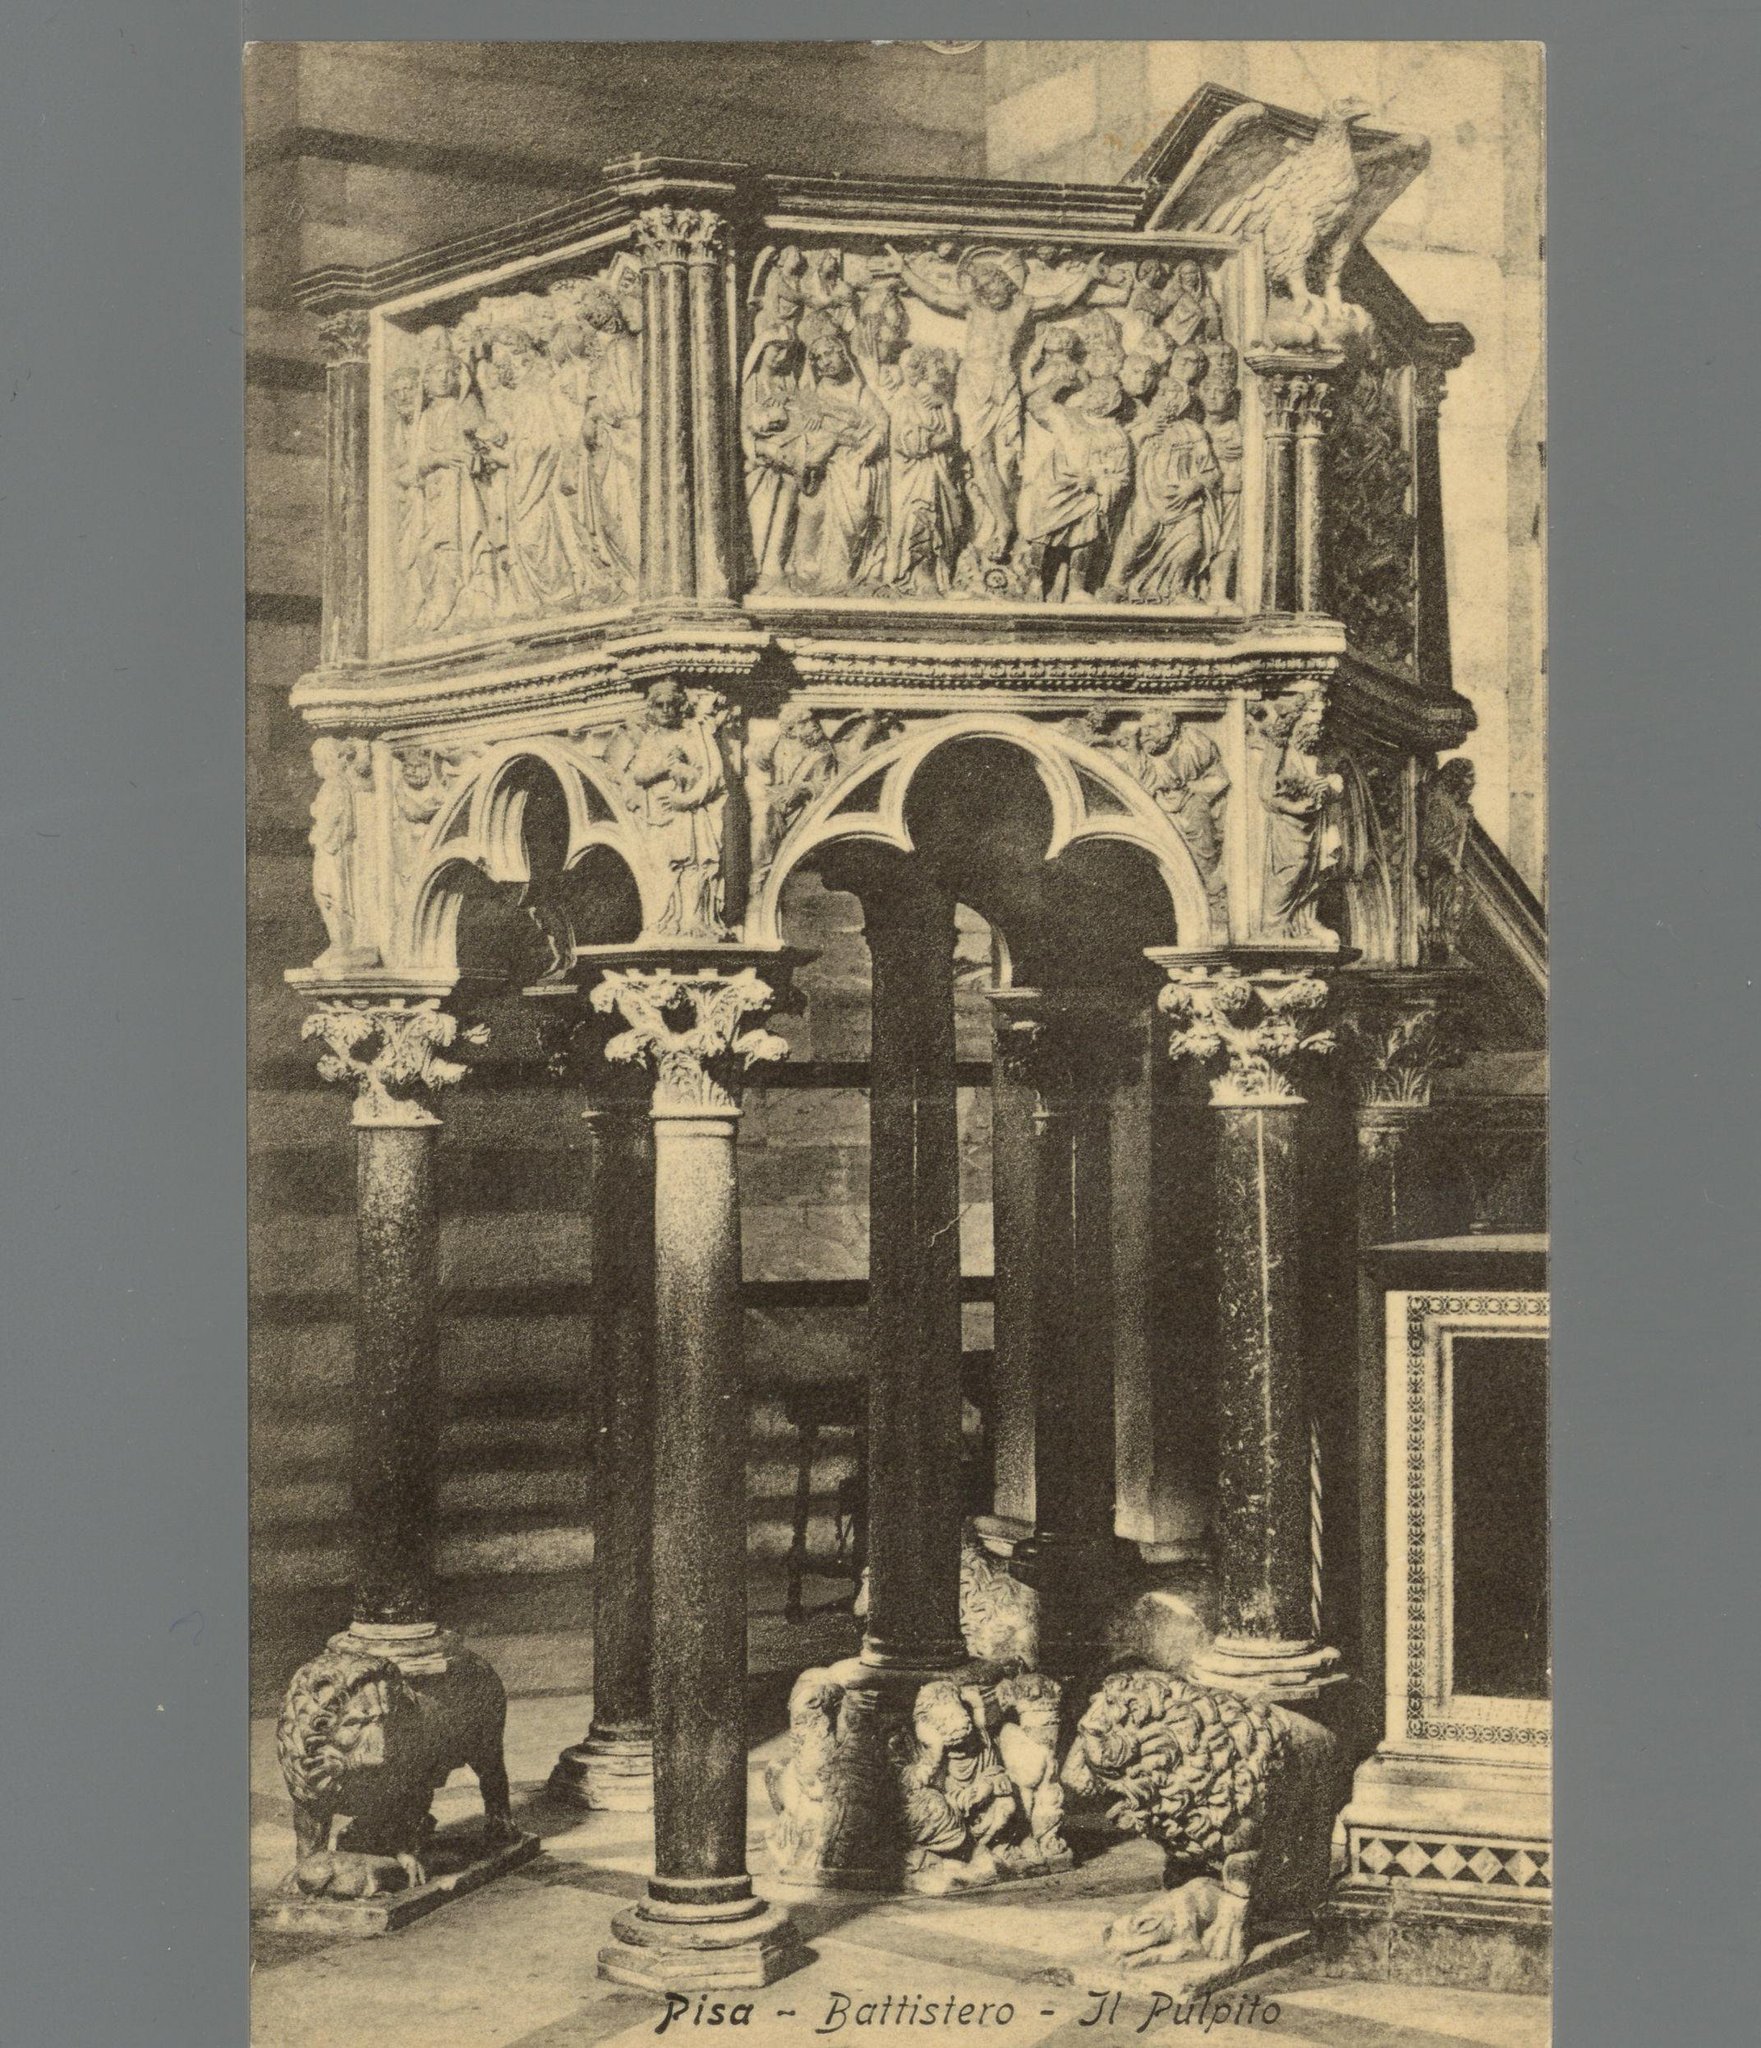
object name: photomechanical print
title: Pisa. Battistero. Il pulpito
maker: Anonymous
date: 1906-1909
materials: cardboard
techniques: photograph, writing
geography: pisa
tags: interior of church, pulpit, ambo, chancel